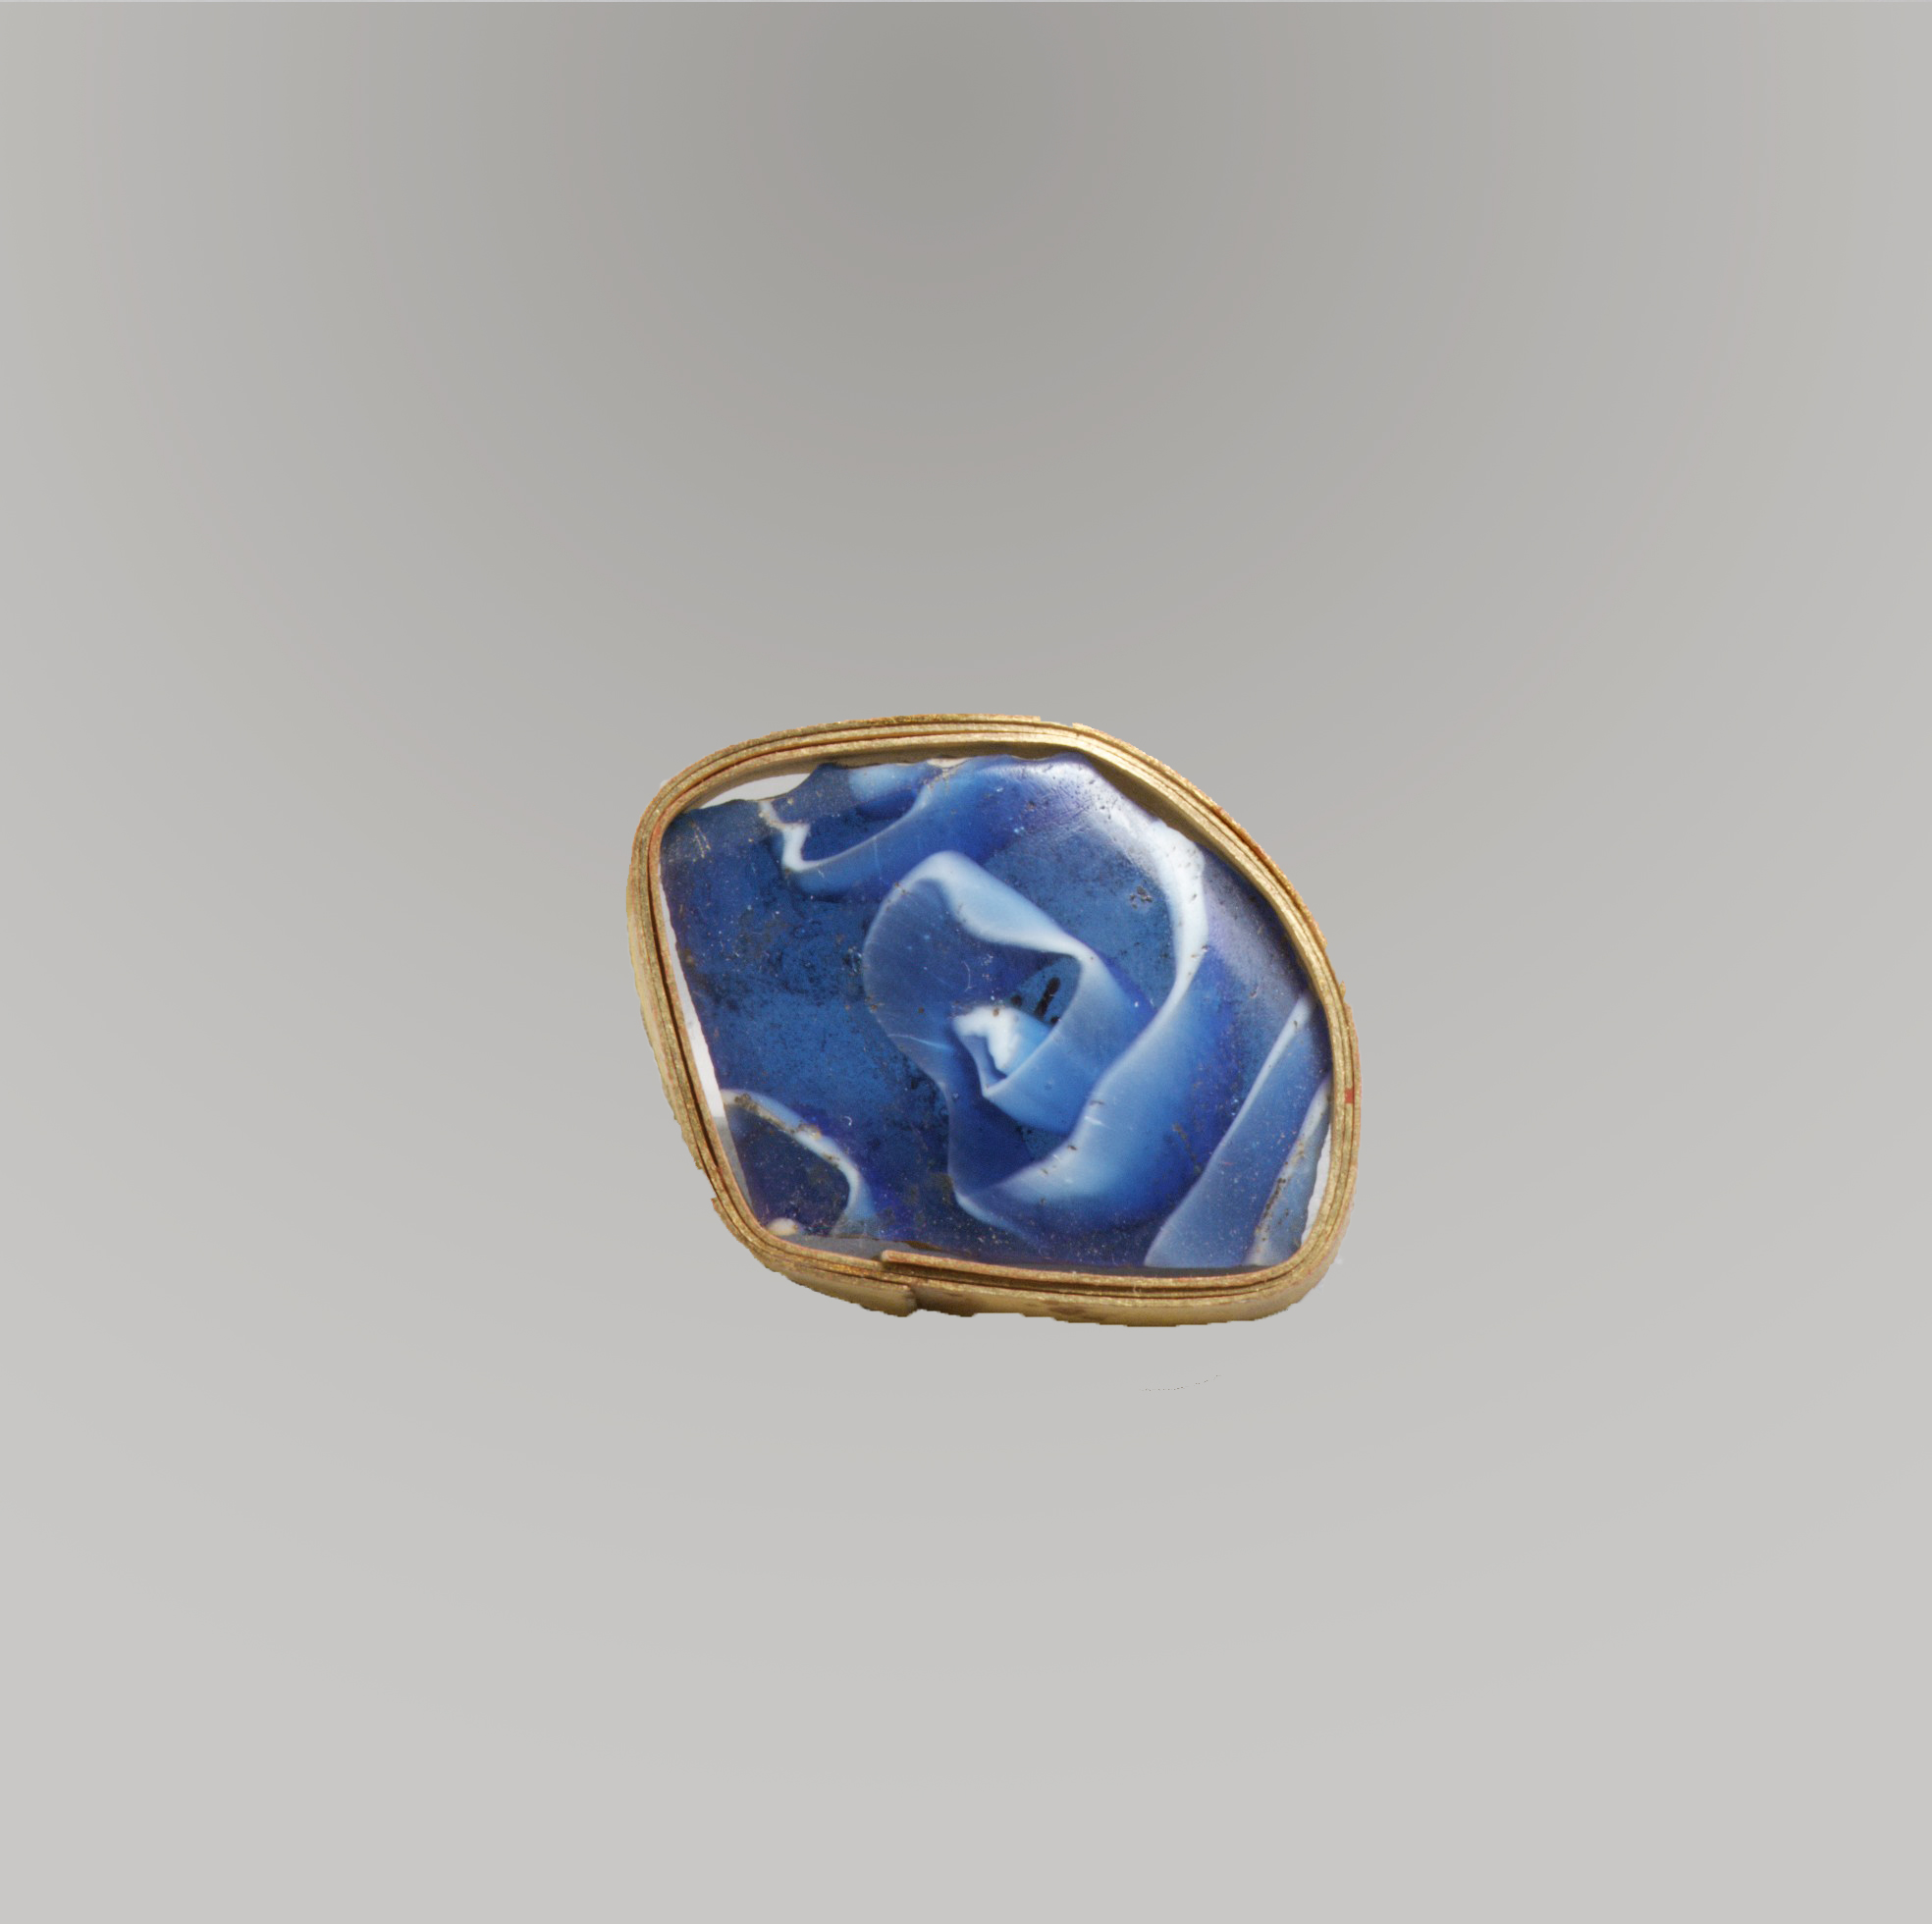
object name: fragment, mosaic bowl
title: Glass mosaic bowl fragment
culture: roman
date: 34 BCE-33 CE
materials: glass